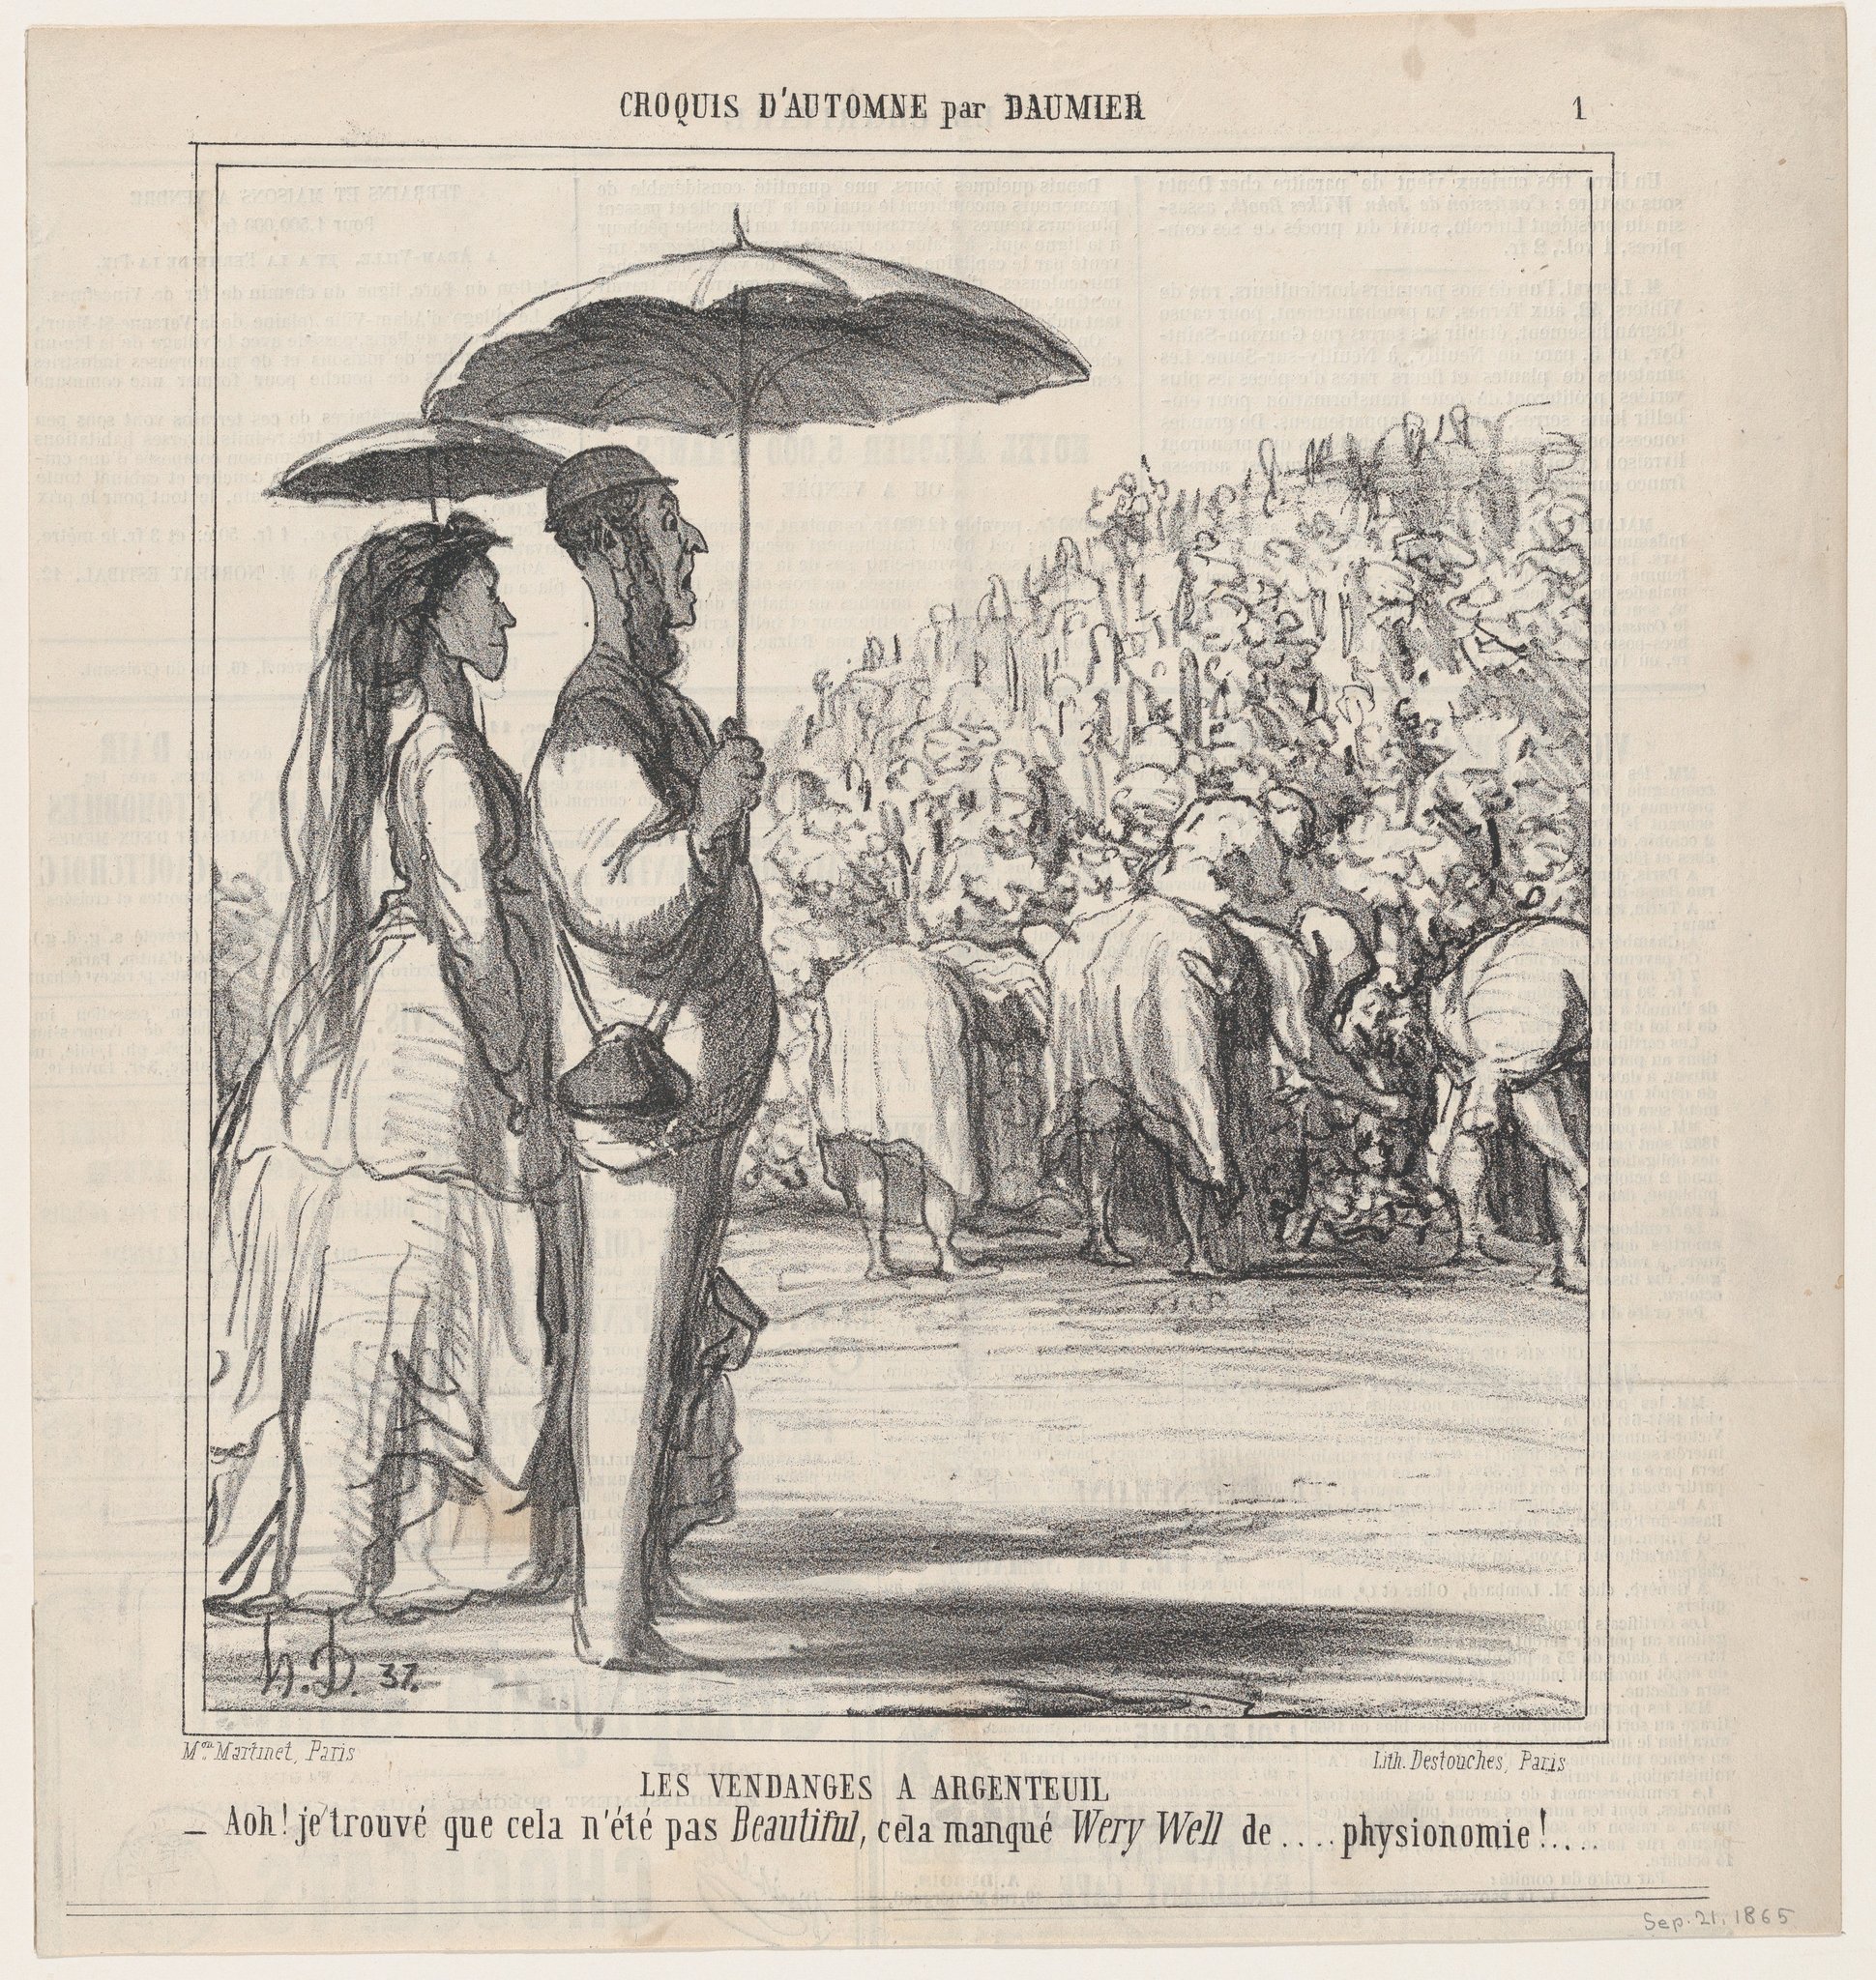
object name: print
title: Wine harvest in Argenteuil, from 'Autumn sketches,' published in Le Charivari, September 21, 1865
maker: honoré daumier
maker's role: artist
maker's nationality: french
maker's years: 1808-1879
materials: paper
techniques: lithograph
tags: satire,men,women,crowd